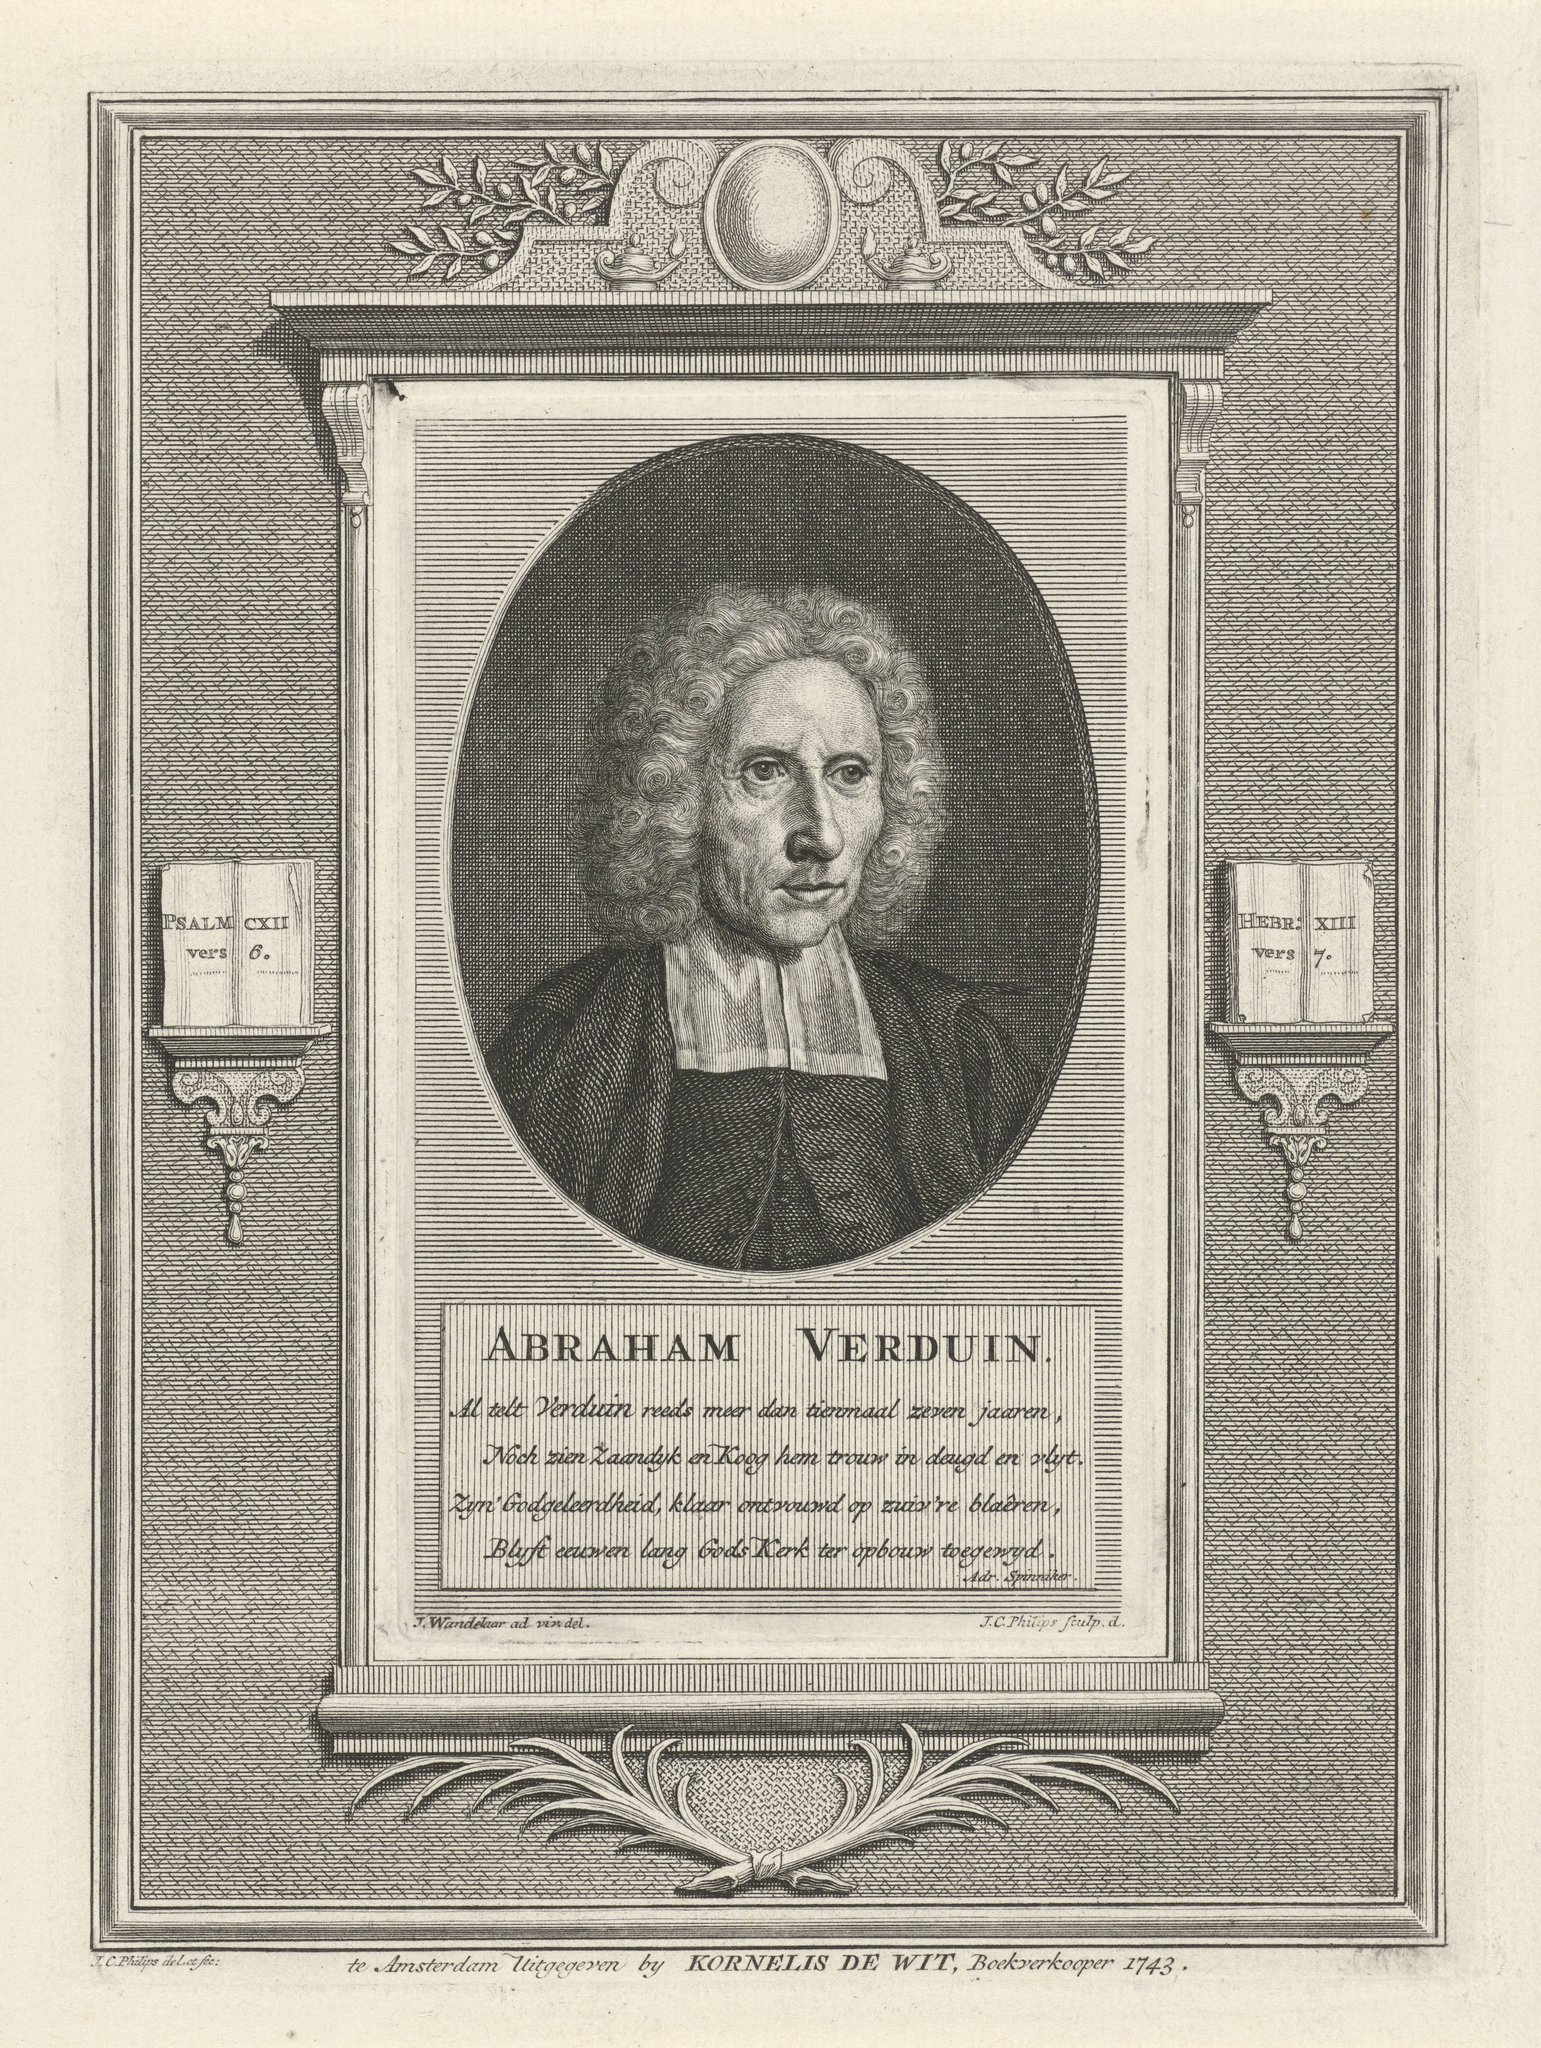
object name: print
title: Verzaameling van de afbeeldingen van veele voornaame mannen en leraaren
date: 1743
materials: paper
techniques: engraving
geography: amsterdam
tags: the bible as a book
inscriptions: collector's mark: Lugt 2228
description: Prent als illustratie gebruikt in: Verzaameling van de afbeeldingen van veele voornaame mannen en leeraaren, die (...) het leeraars ampt onder de doopsgezinde christenen bediend hebben. Amsterdam: Kornelis de Wit, 1743.